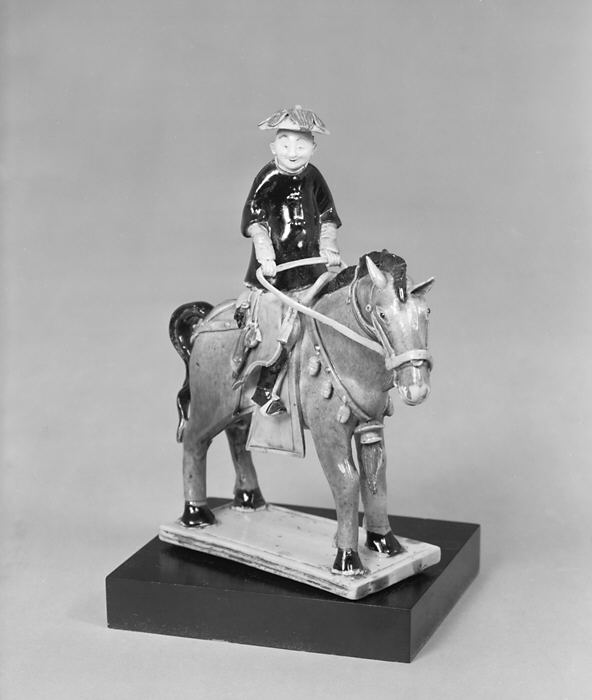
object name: figure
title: Figure of Gentleman on Horseback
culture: chinese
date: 1662-1722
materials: biscuit, enamel, porcelain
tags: men,horses